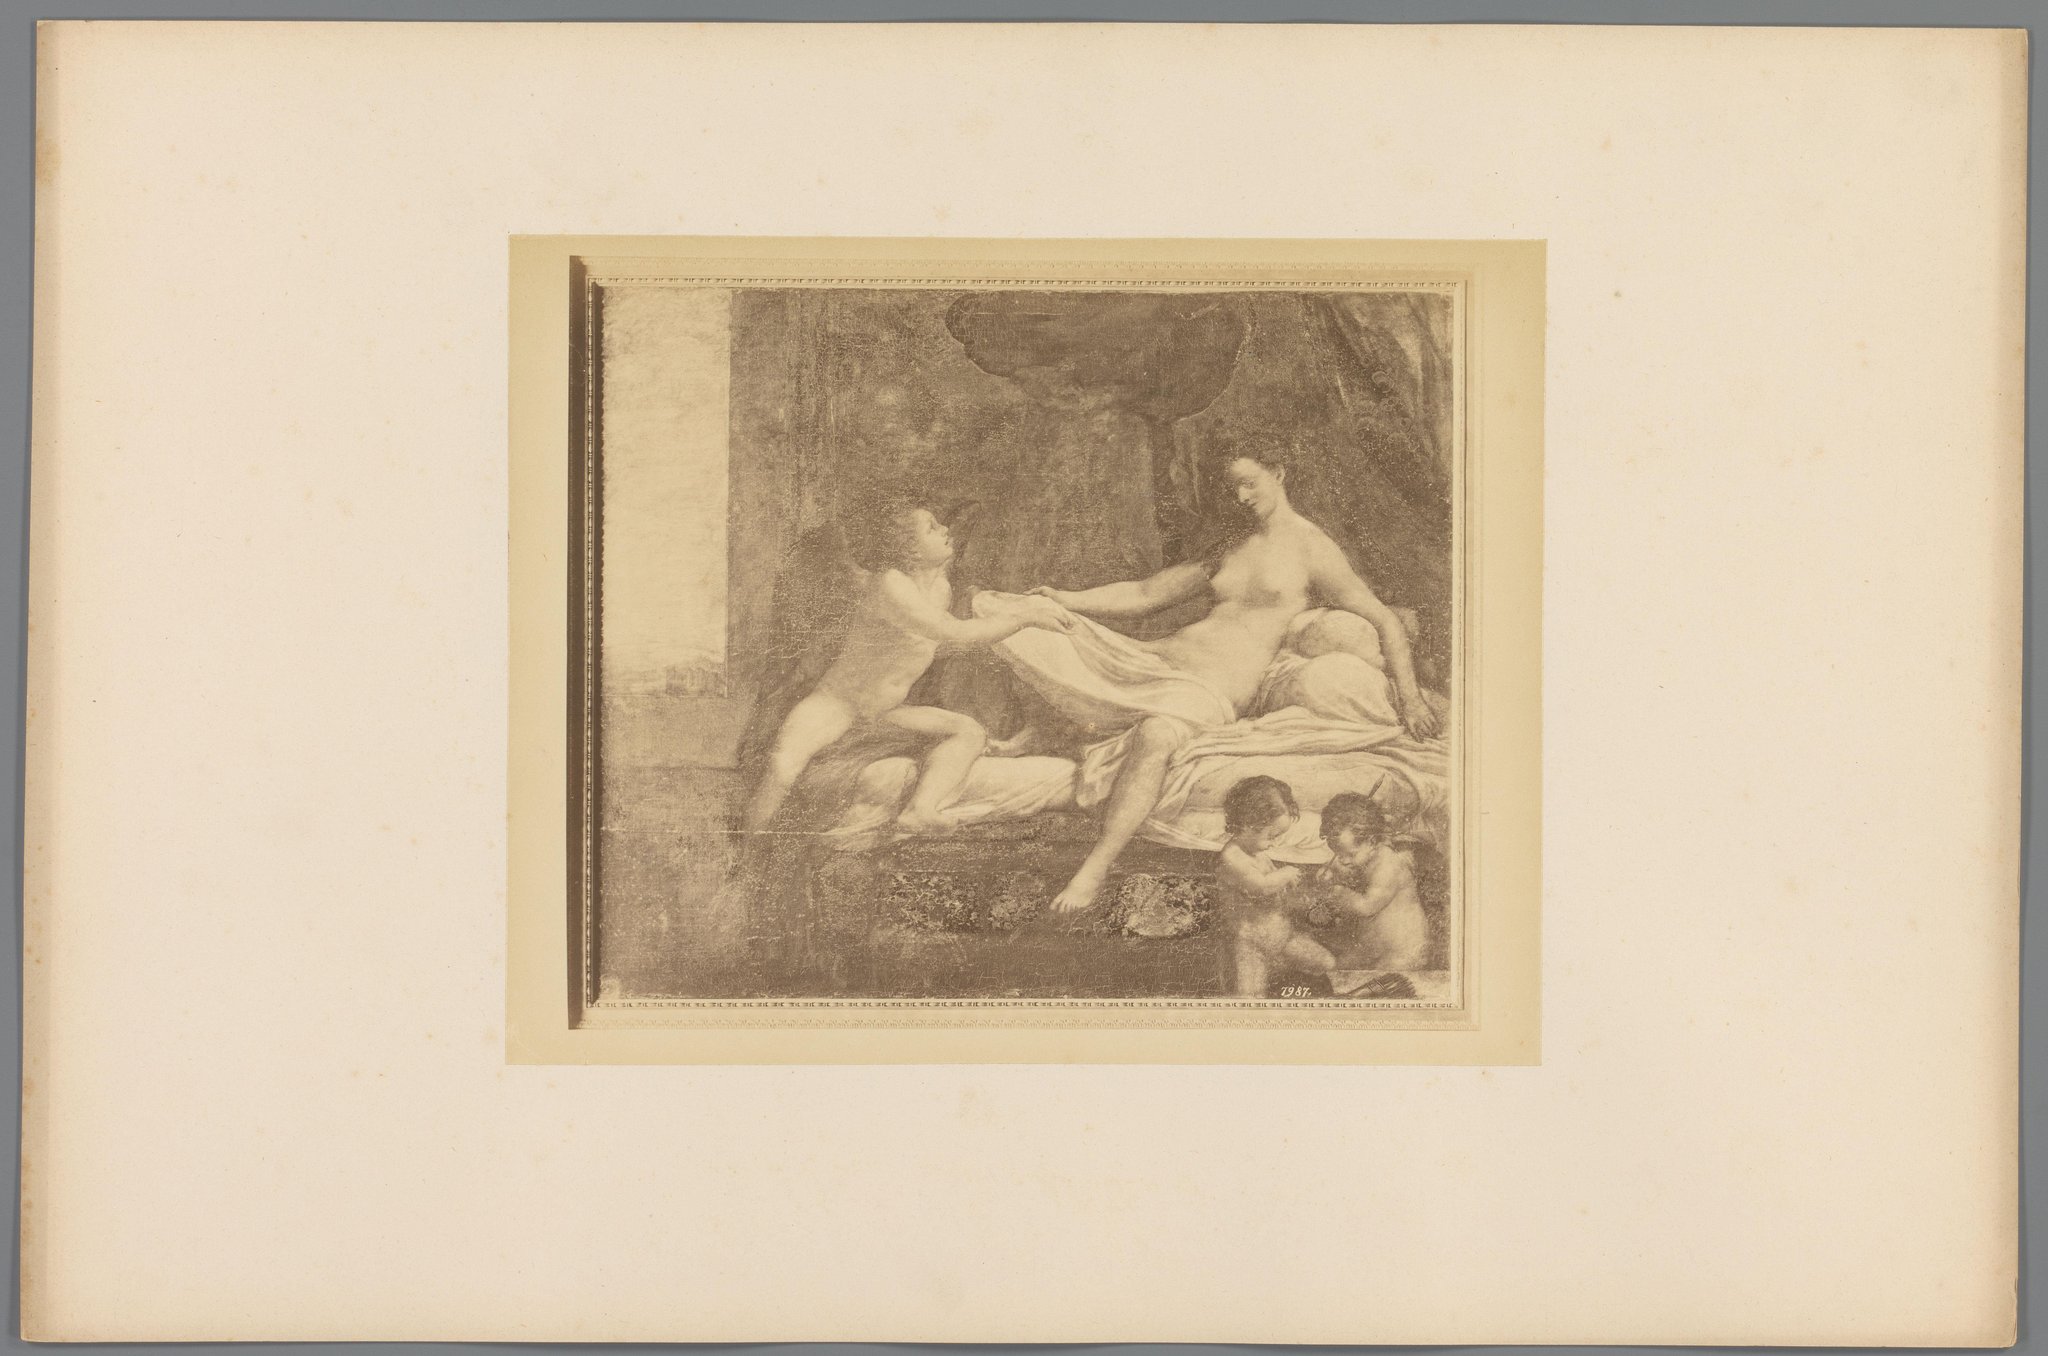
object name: photograph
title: Fotoreproductie van het schilderij Danaë naar Correggio in de Galleria Borghese te Rome, Italië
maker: Anonymous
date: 1851-1900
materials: cardboard, paper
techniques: albumen print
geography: rome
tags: jupiter wooing danae; she is usually lying in bed receiving a shower of gold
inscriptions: number: ‘7987’